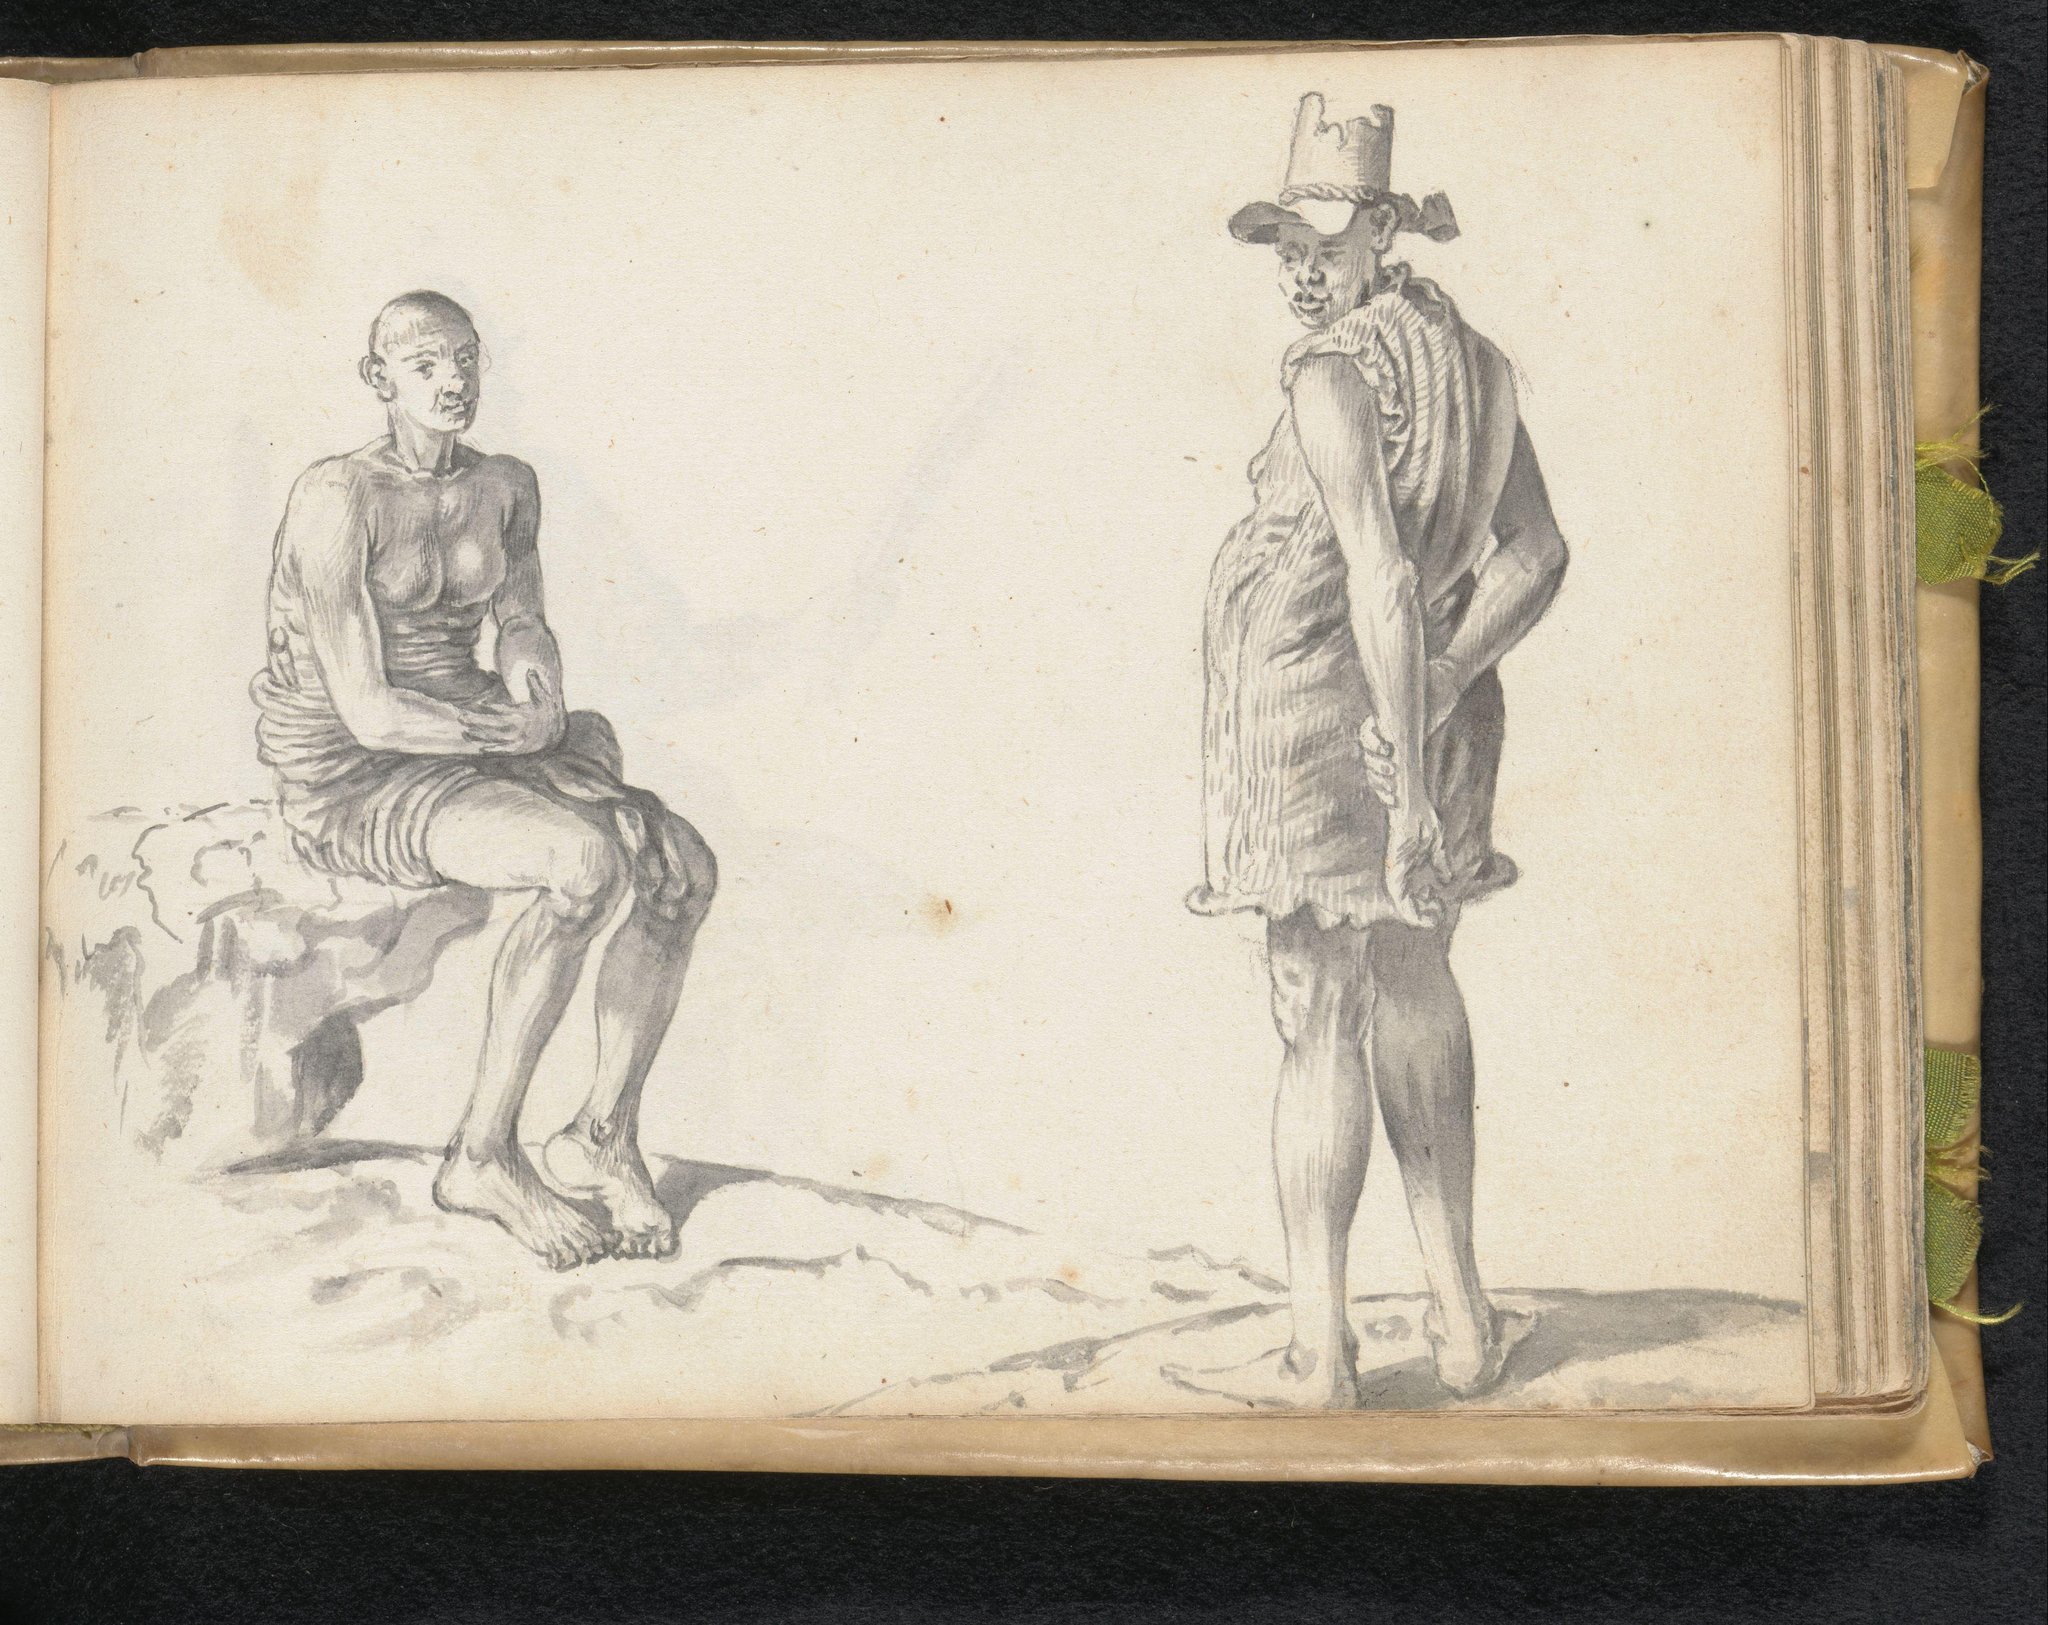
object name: sketchbook leaf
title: Two labourers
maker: esaias boursse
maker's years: 1631-1672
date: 1662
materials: ink, paper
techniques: brush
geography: sri lanka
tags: 41d232(...) skirt (lungi), head-gear (with name), clothing for the upper part of the body (with name), asiatic races and peoples: indians, sri lanka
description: Links op een rotsblok langs een oneffen terrein zit een man. Een hoog opgetrokken heupkleed (veshti, lungi) laat zijn benen onbedekt, evenals het bovenlijf. Rechts in zijn taille steekt een voorwerp omhoog, wellicht een handvat van een mes. De staande man rechts gaat gekleed in een lang hemd (kamisaya) van gestreepte stof – zonder mouwen –, dat rijkt tot halverwege het dijbeen. Op het kale hoofd draagt hij een versleten hoed (toppiya) met hoedenkoord. Beide mannen zijn waarschijnlijk in Colombo te werk gesteld aan de wederopbouw: de linker man afkomstig van Zuid-India, de rechter een toepas van Jaffna. Blad 68 uit een schetsboek met 117 bladen.